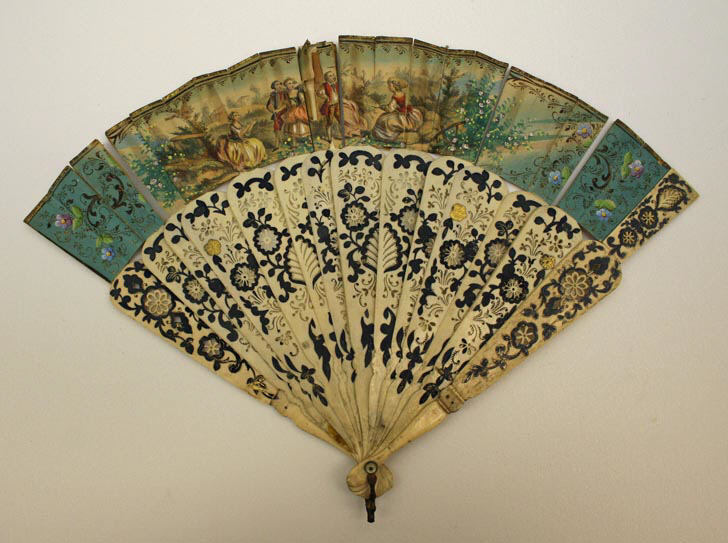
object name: fan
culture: french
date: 1834-1866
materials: ivory, paper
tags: men,women